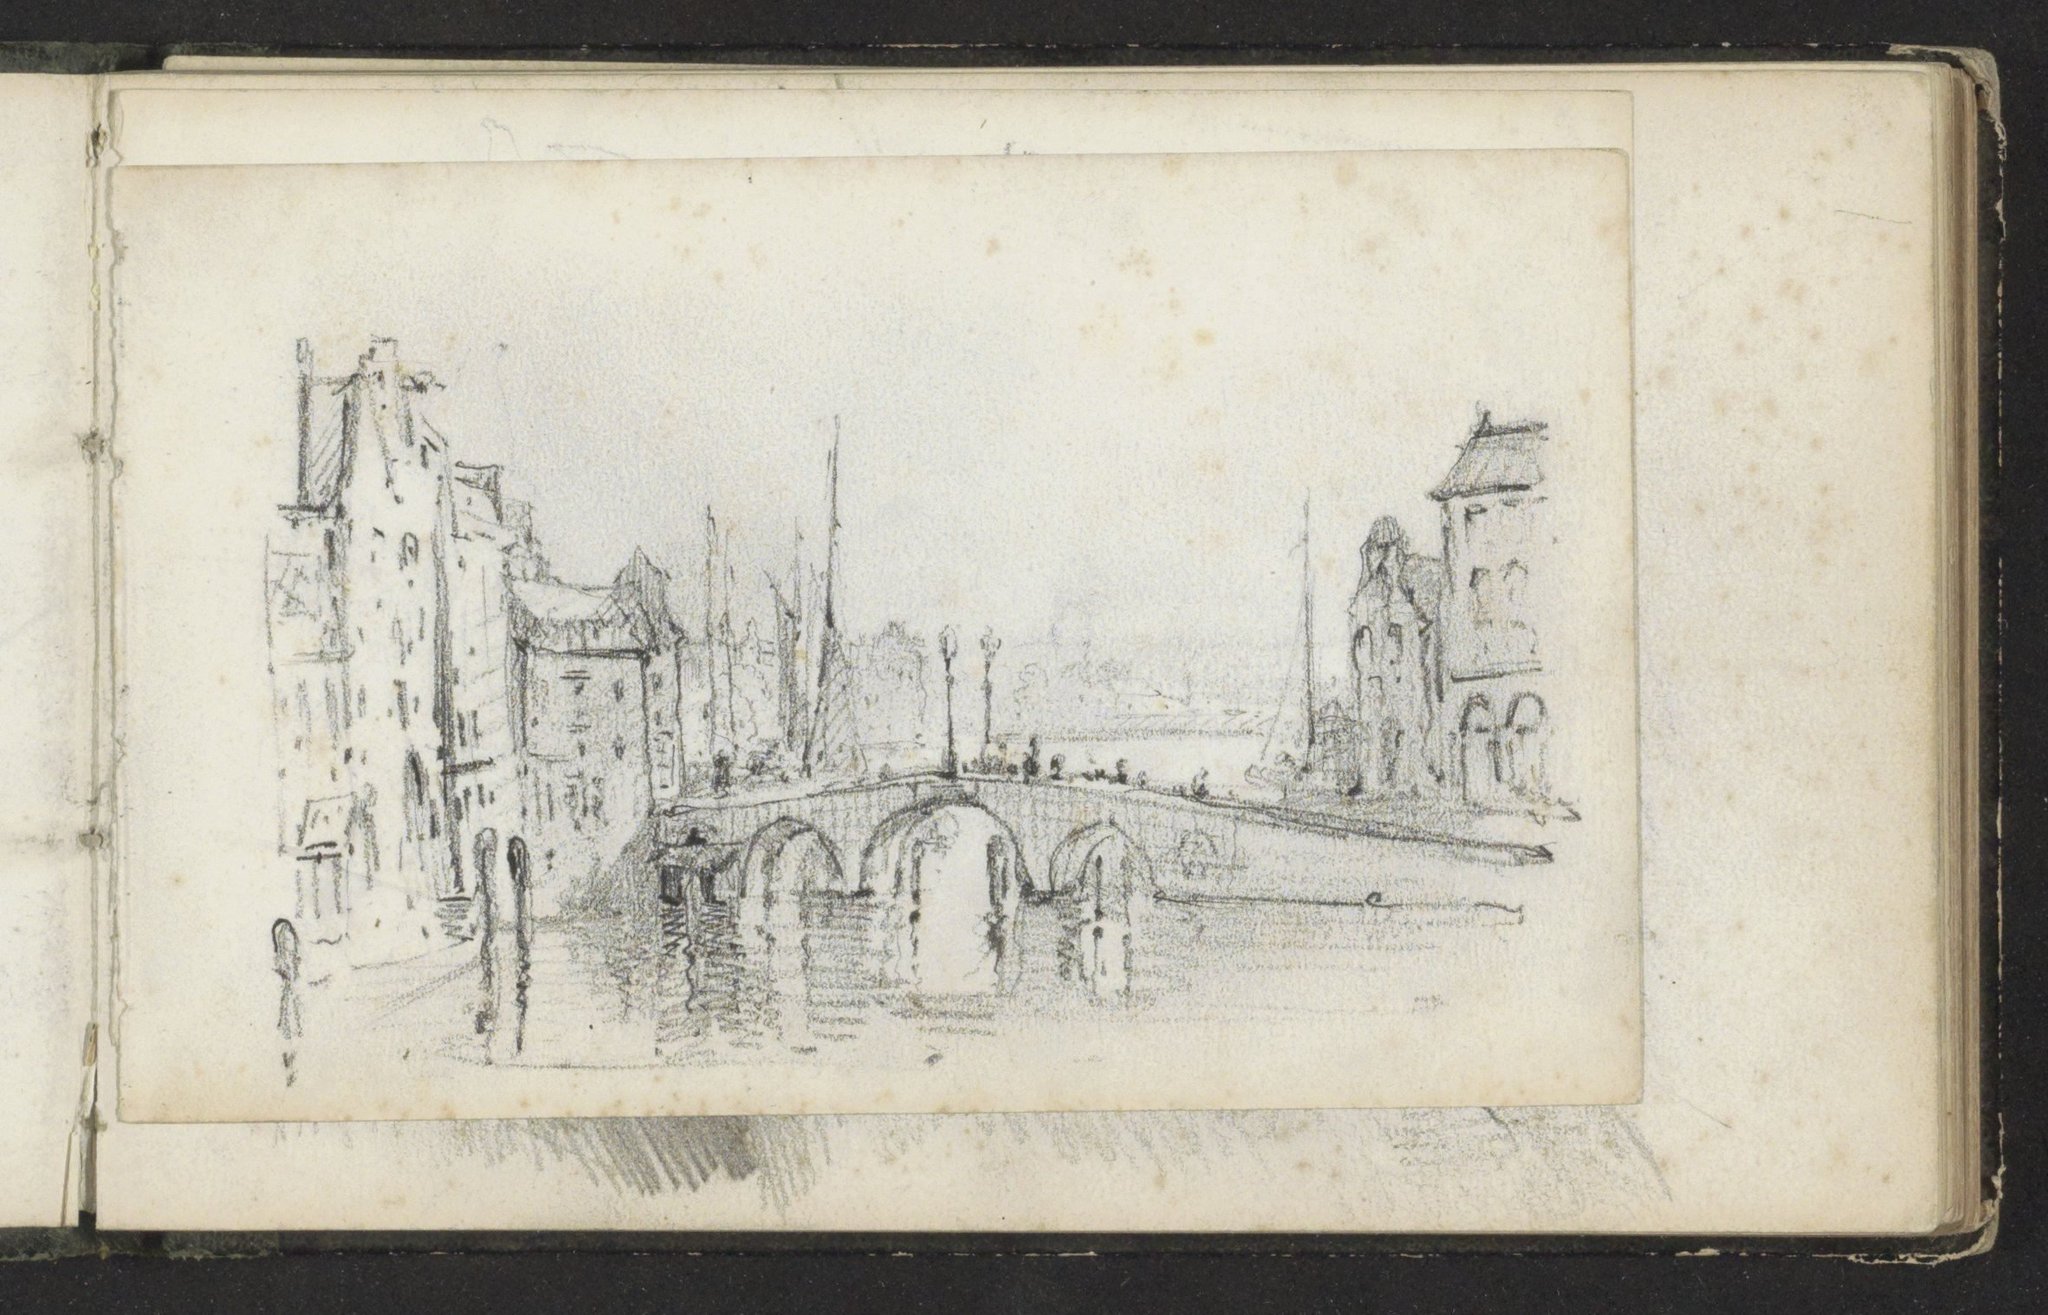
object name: sketchbook leaf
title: Stadsgezicht met een brug over een rivier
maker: maria vos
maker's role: draughtsman, painter, print maker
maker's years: 1824-1906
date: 1856-1870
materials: paper, pencil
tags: city-view, and landscape with man-made constructions, bridge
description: Losse tekening tussen het voorste schutblad en pagina 1 recto van een schetsboek met 39 bladen.